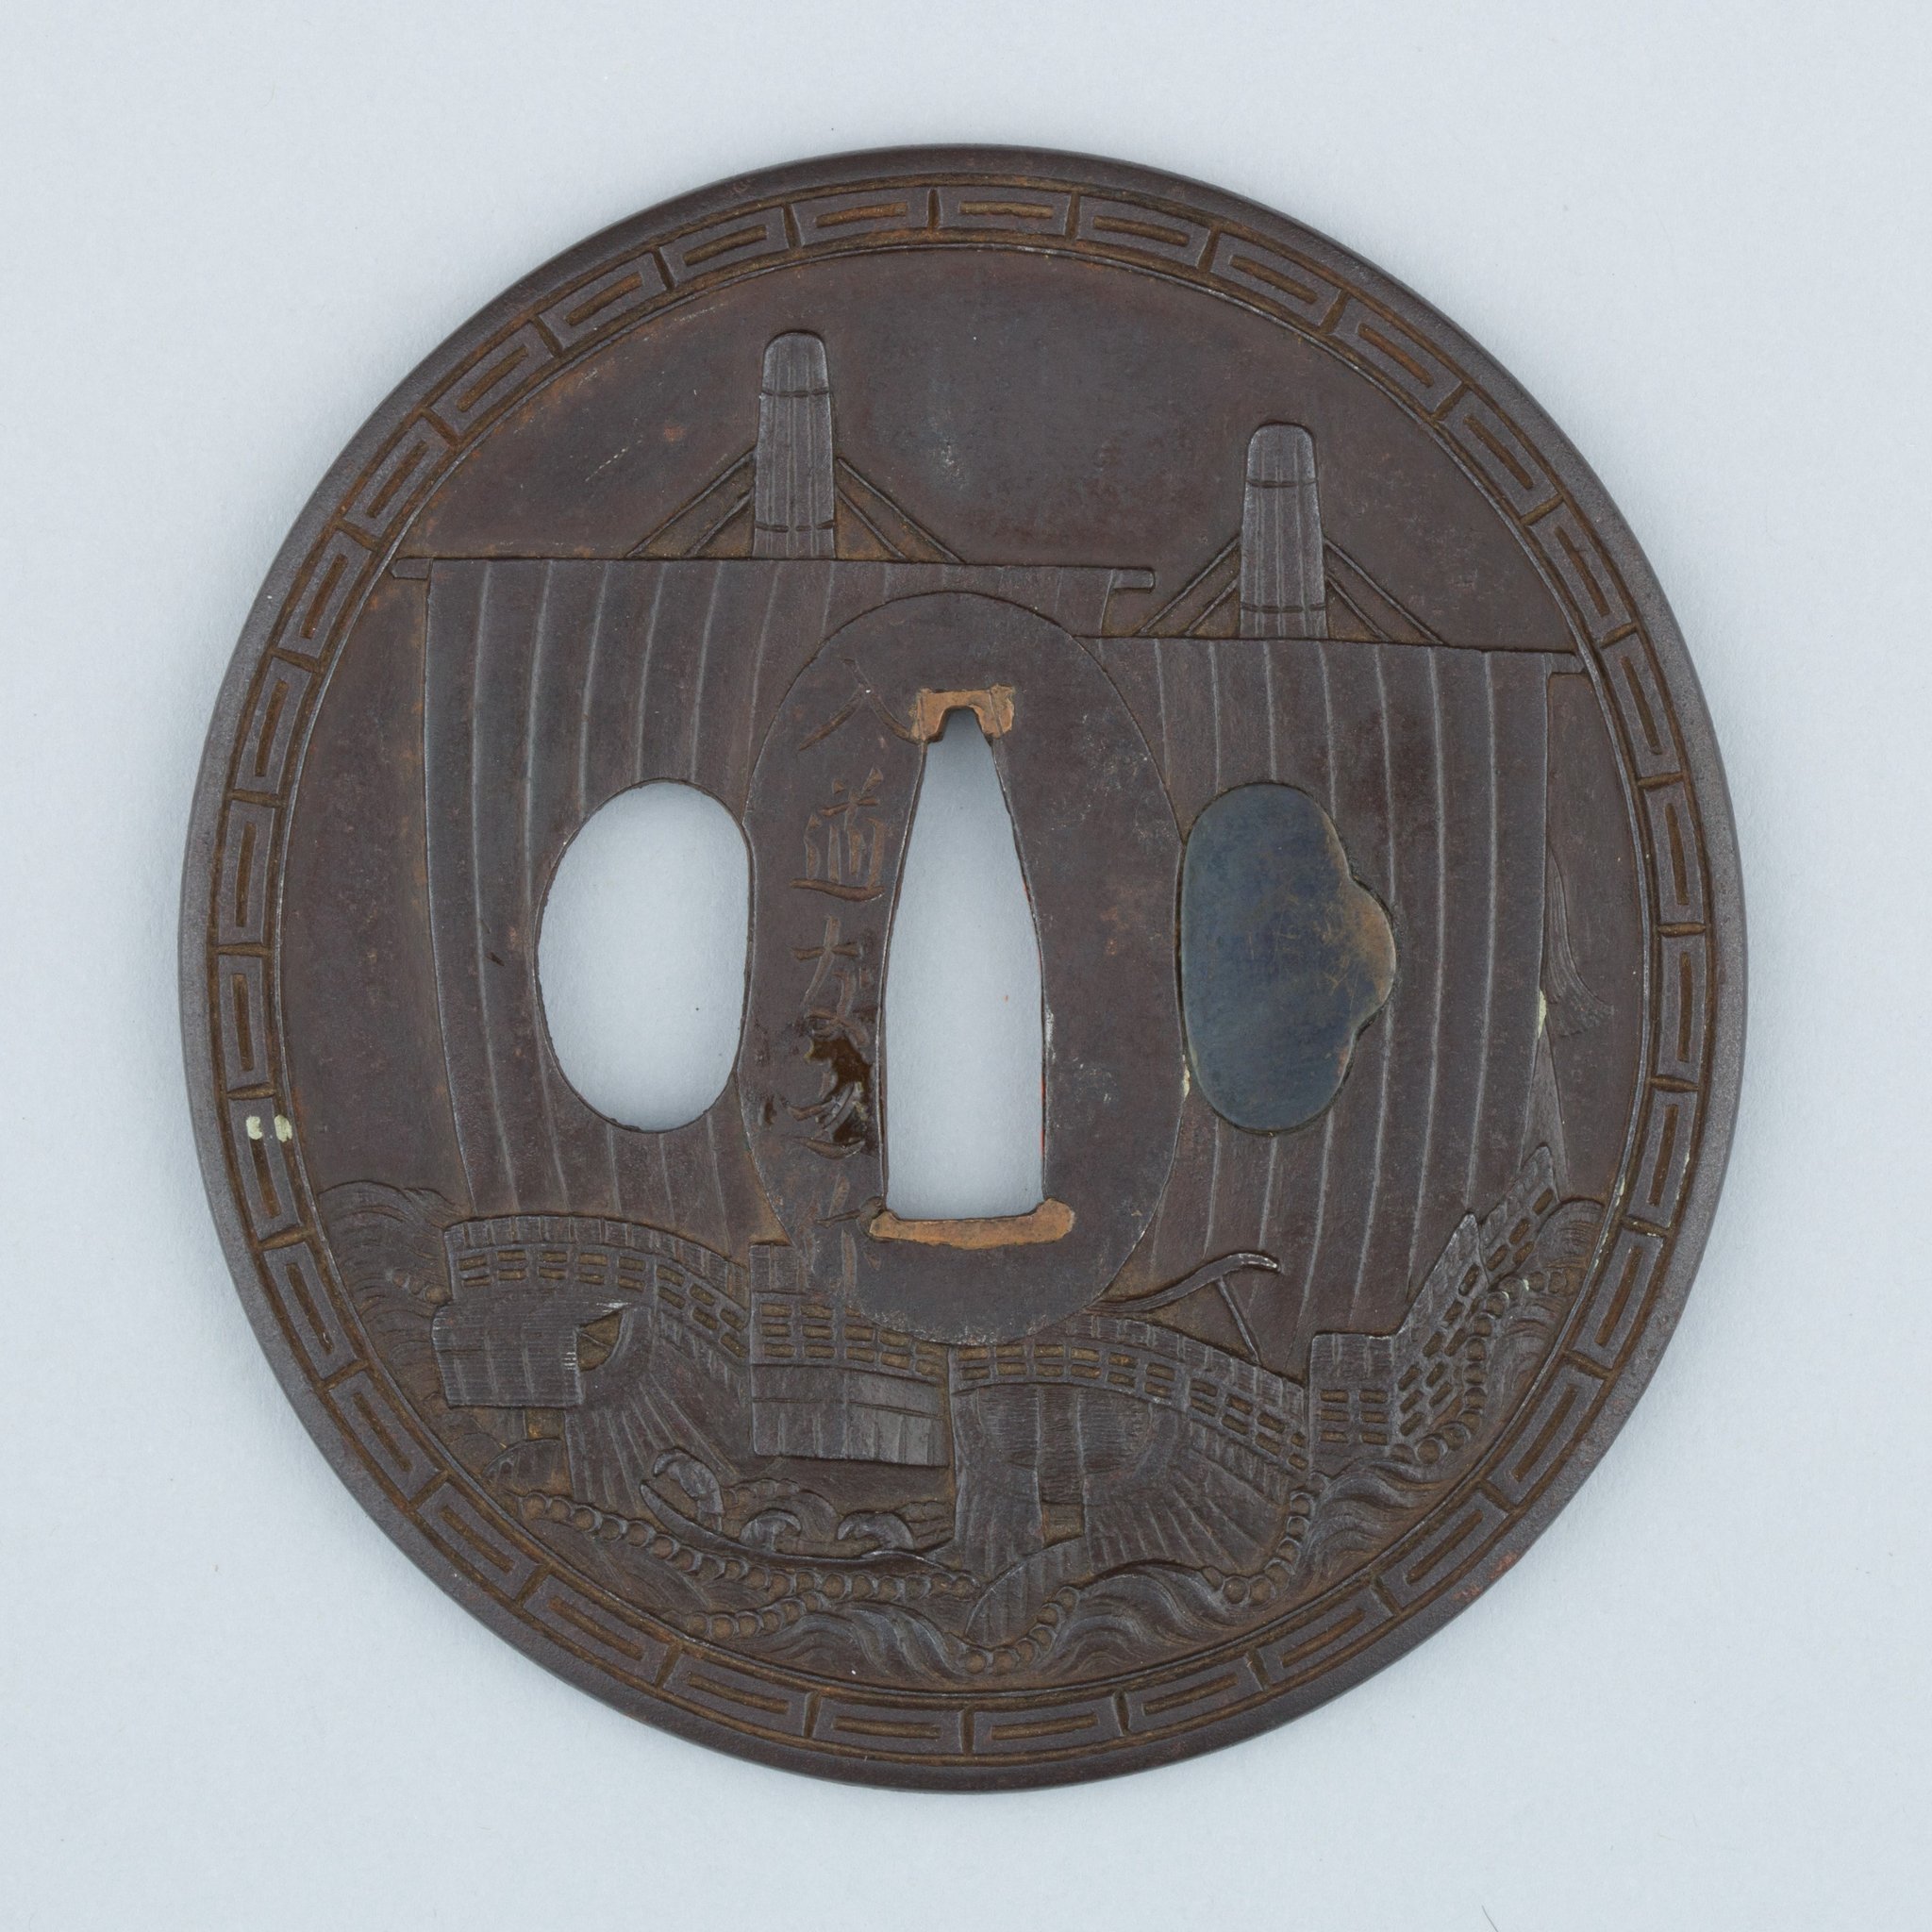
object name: sword guard tsuba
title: Sword Guard (Tsuba)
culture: japanese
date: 1701-1800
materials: copper, iron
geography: japan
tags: boats